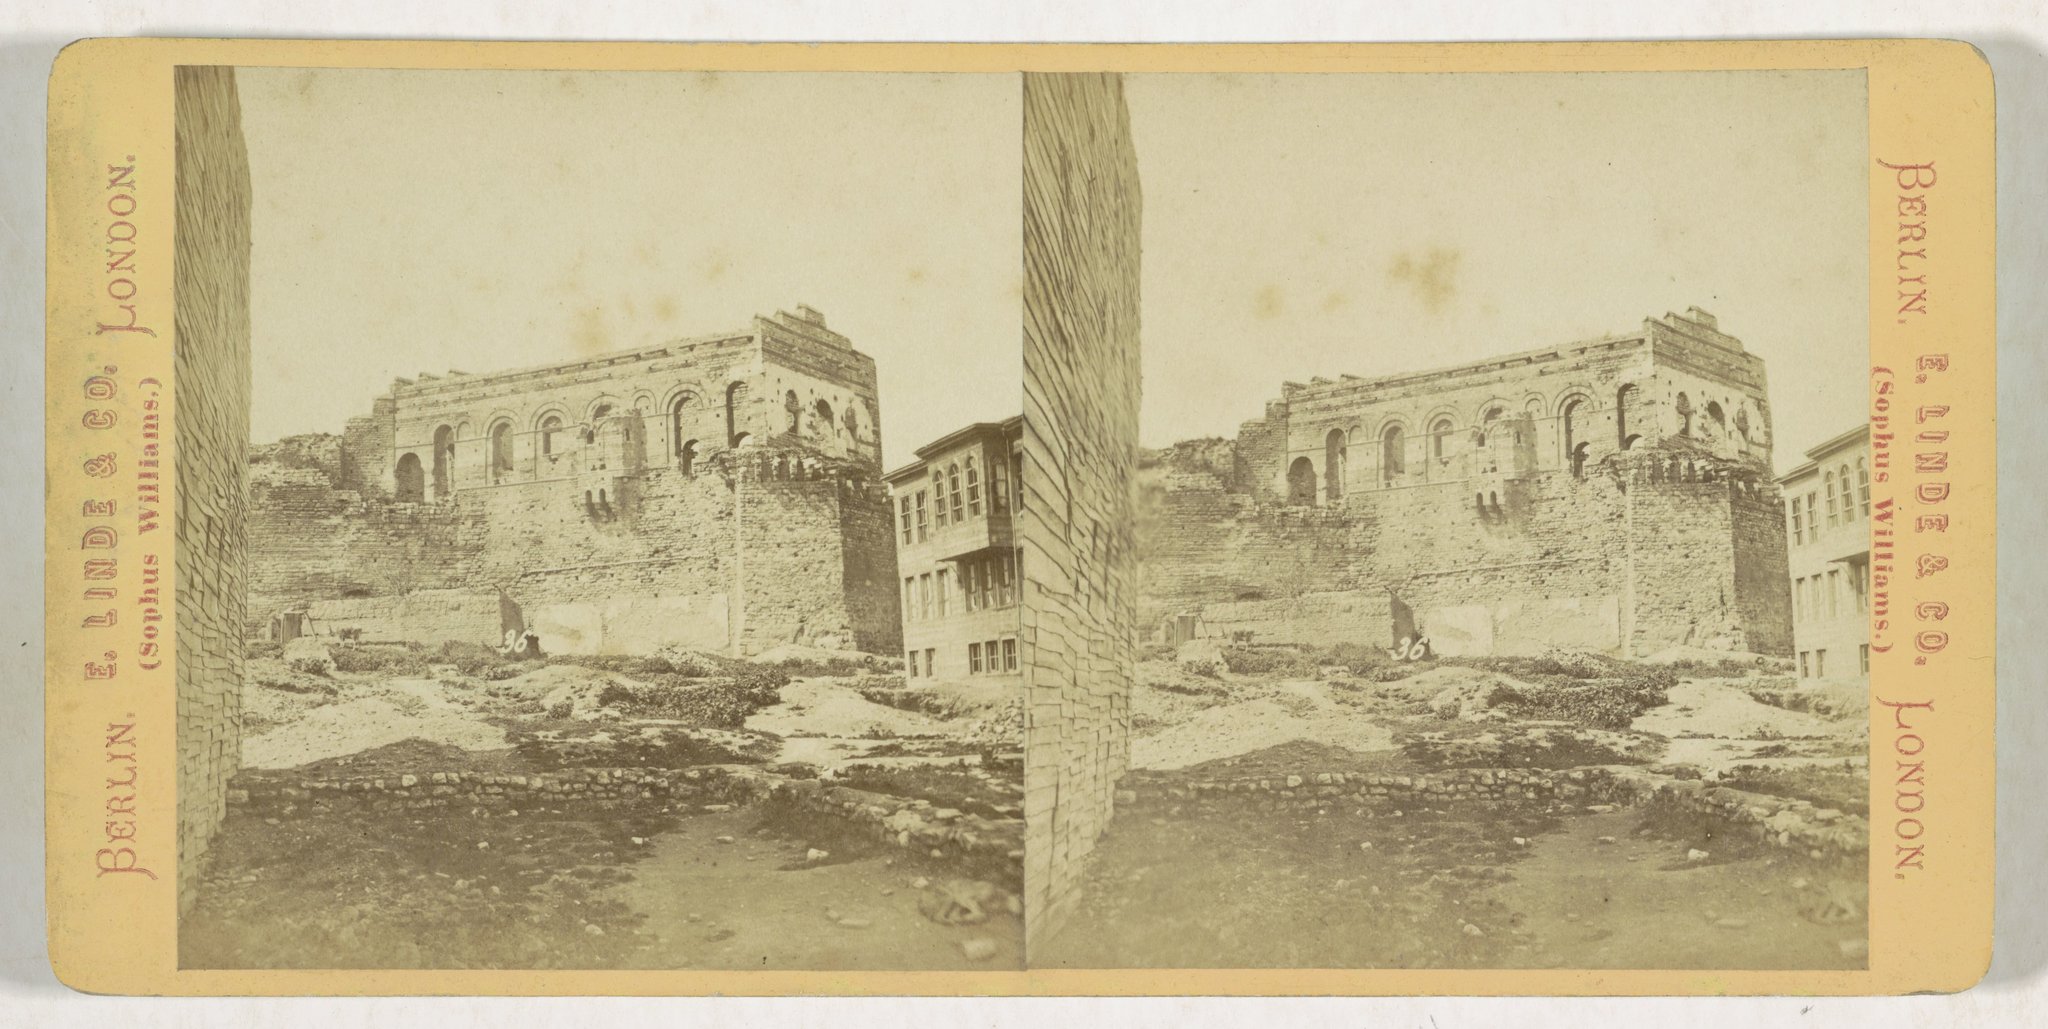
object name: stereograph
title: Constantinopel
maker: Anonymous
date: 1873-1890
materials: cardboard, paper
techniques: albumen print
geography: berlin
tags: palace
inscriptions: number: ‘36’